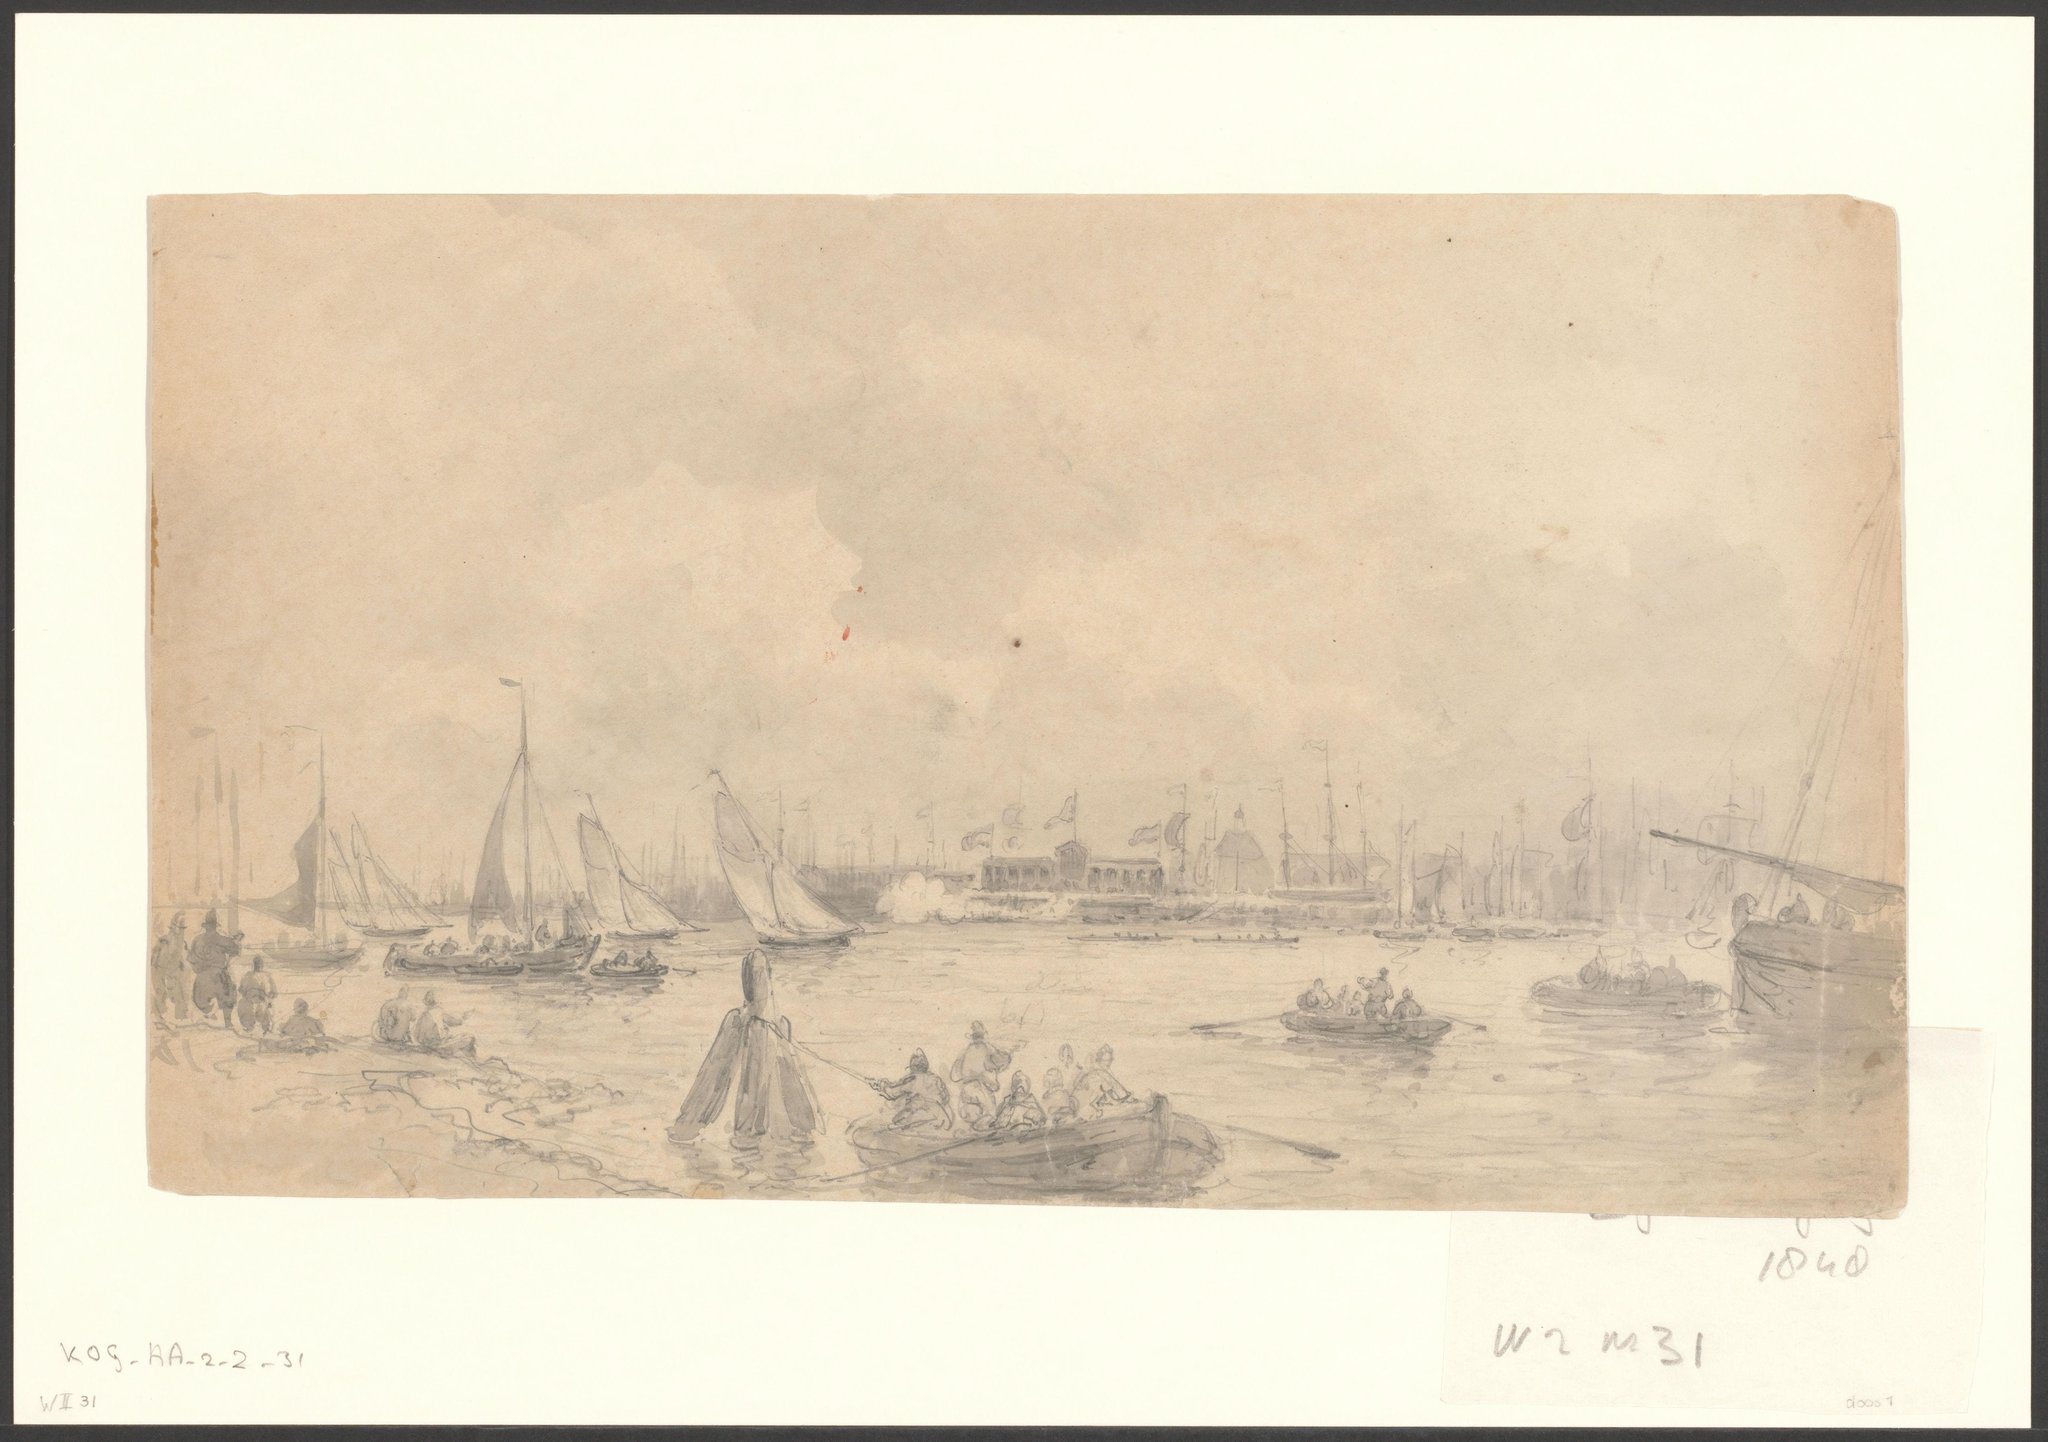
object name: drawing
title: Gezicht op de eerste wedstrijd van de Koninklijke Roei- en Zeilvereniging in 1848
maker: johannes hilverdink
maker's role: draughtsman, painter, print maker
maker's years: 1813-1902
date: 1848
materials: ink, paper, pencil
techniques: brush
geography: amsterdam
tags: sport-tournament, sailing-ship, sailing-boat, city-view in general; 'veduta', rowing, canoeing, etc. (sport), amsterdam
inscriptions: collector's mark: Lugt 800a, inscription: ‘Yachtclub / door Joh. Hilverdink’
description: Tekening binnen de Atlas Van Eck ingedeeld op wijknummer 2.